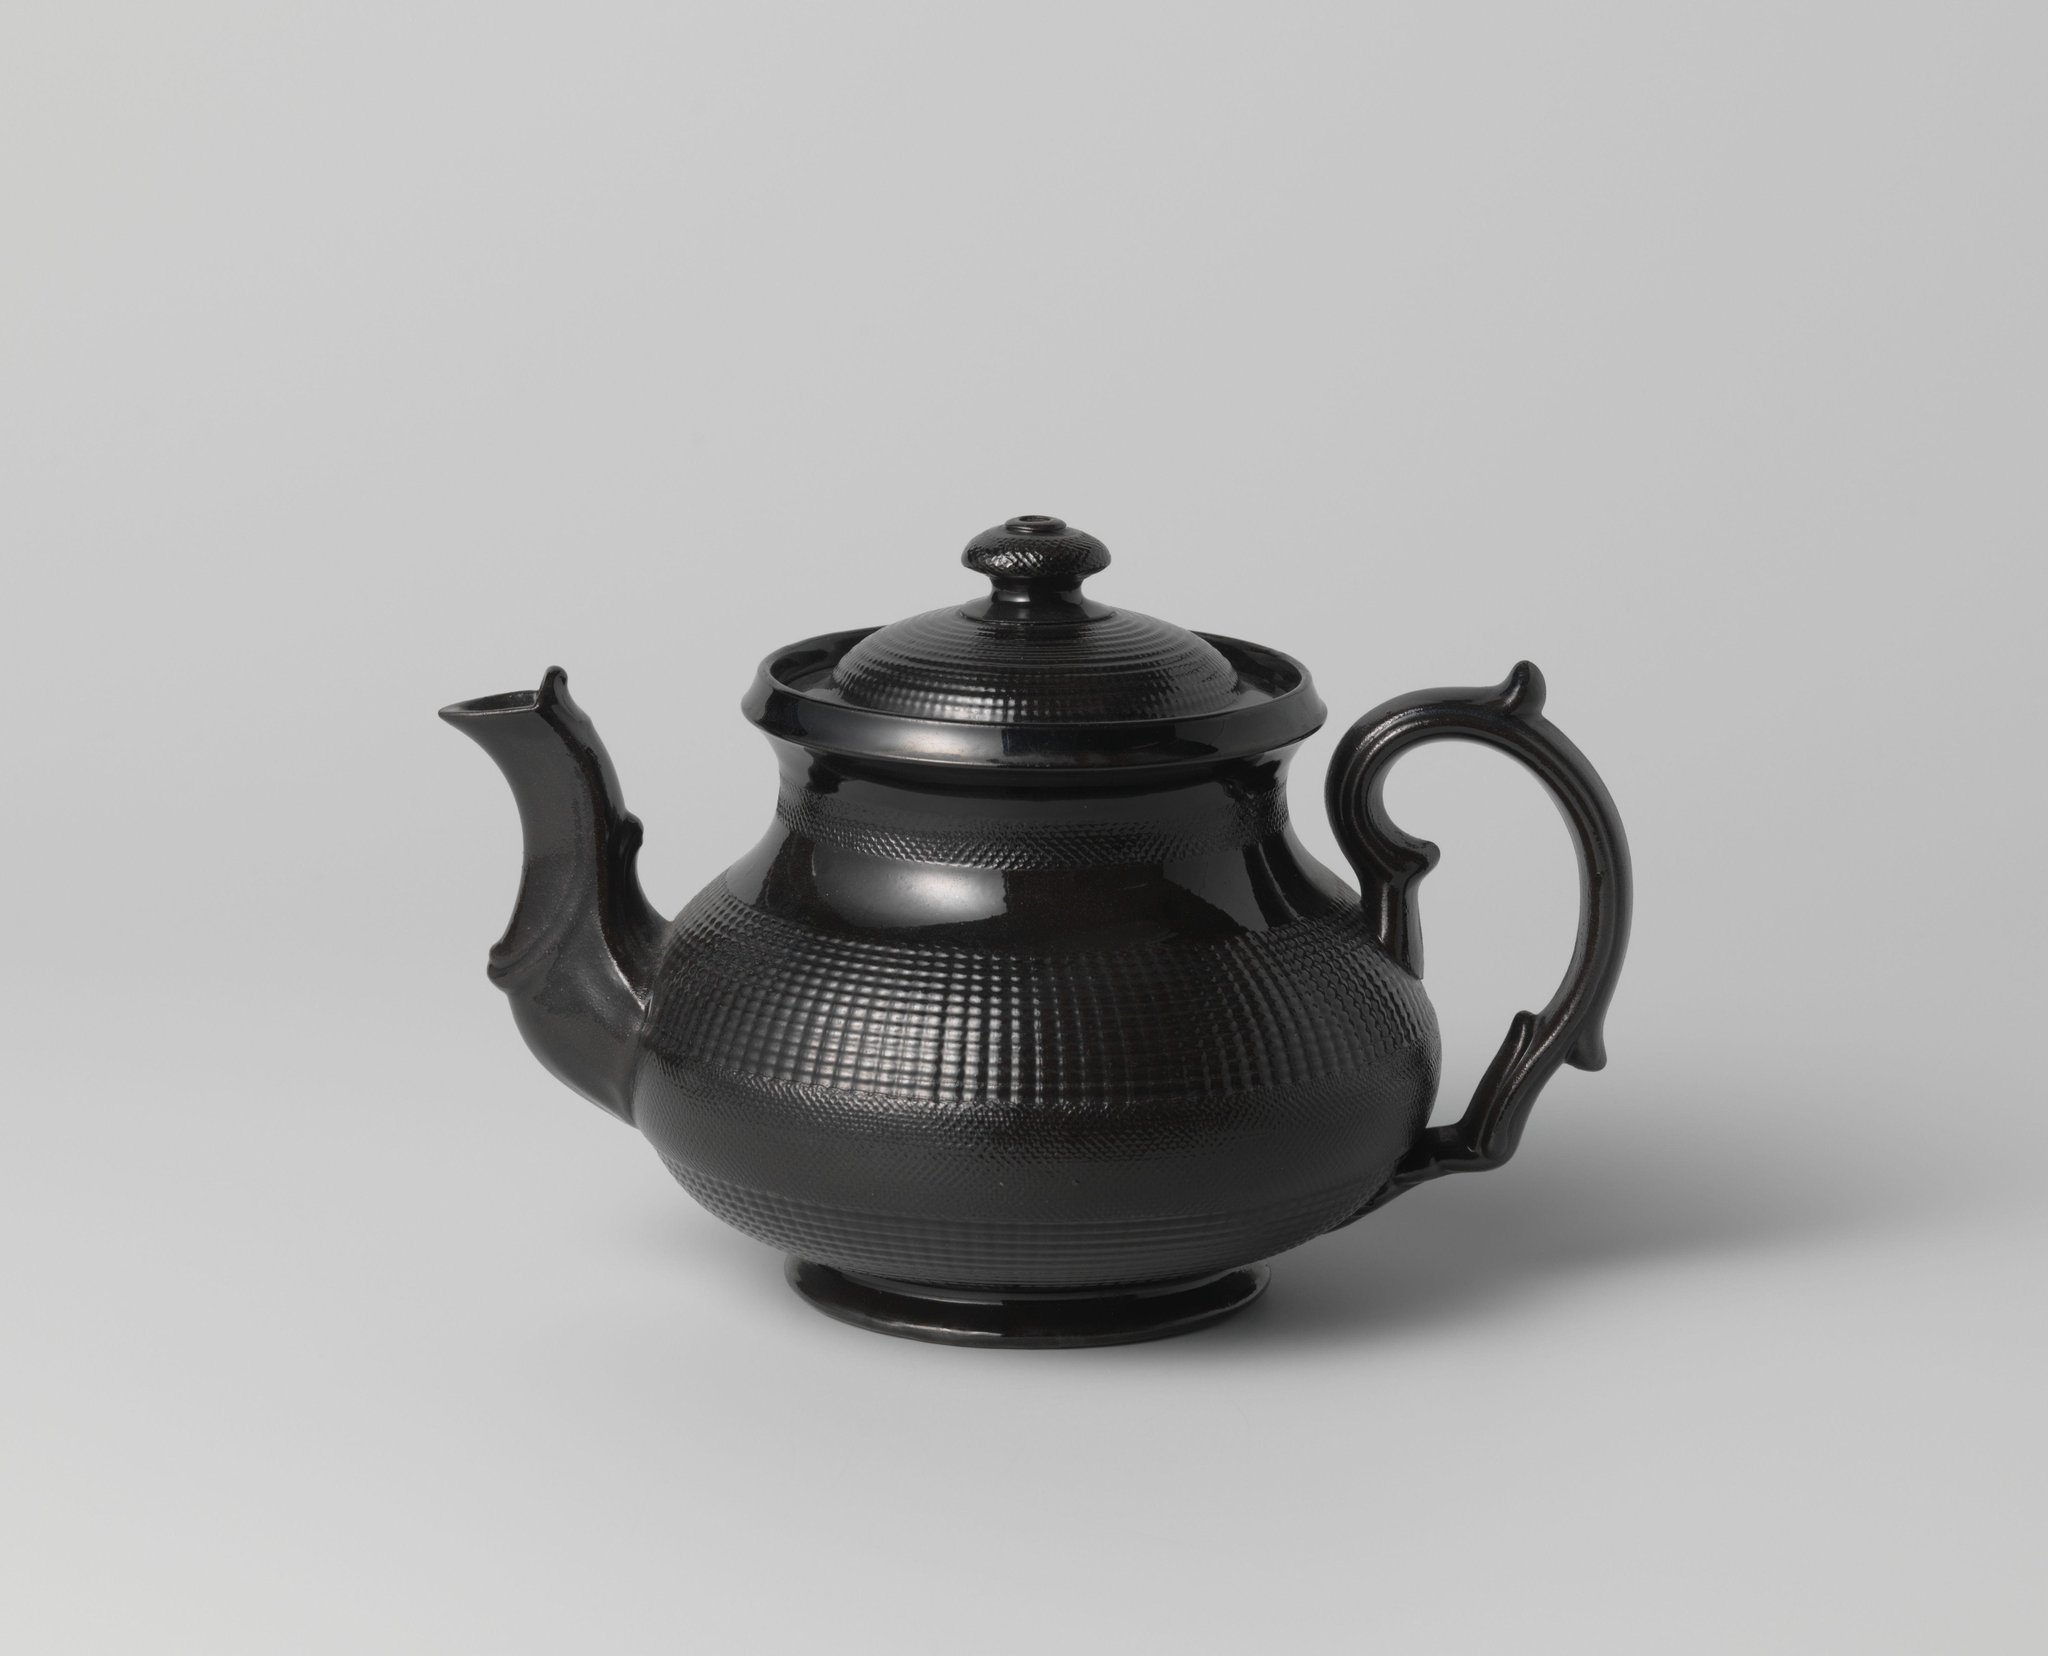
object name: teapot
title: Theepot, zwart, gedecoreerd met ribbelranden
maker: petrus regout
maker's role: plateelbakker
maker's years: 1801-1879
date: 1860-1880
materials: stoneware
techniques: engels steengoed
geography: maastricht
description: Theepot van zwartsteen. Het lichaam met dicht op elkaar gelegen ribbelranden. De s-vormige tuit met voluten in reliëf. Het c-vormige handvat eindigt aan de onderzijde in een gestileerd blad.